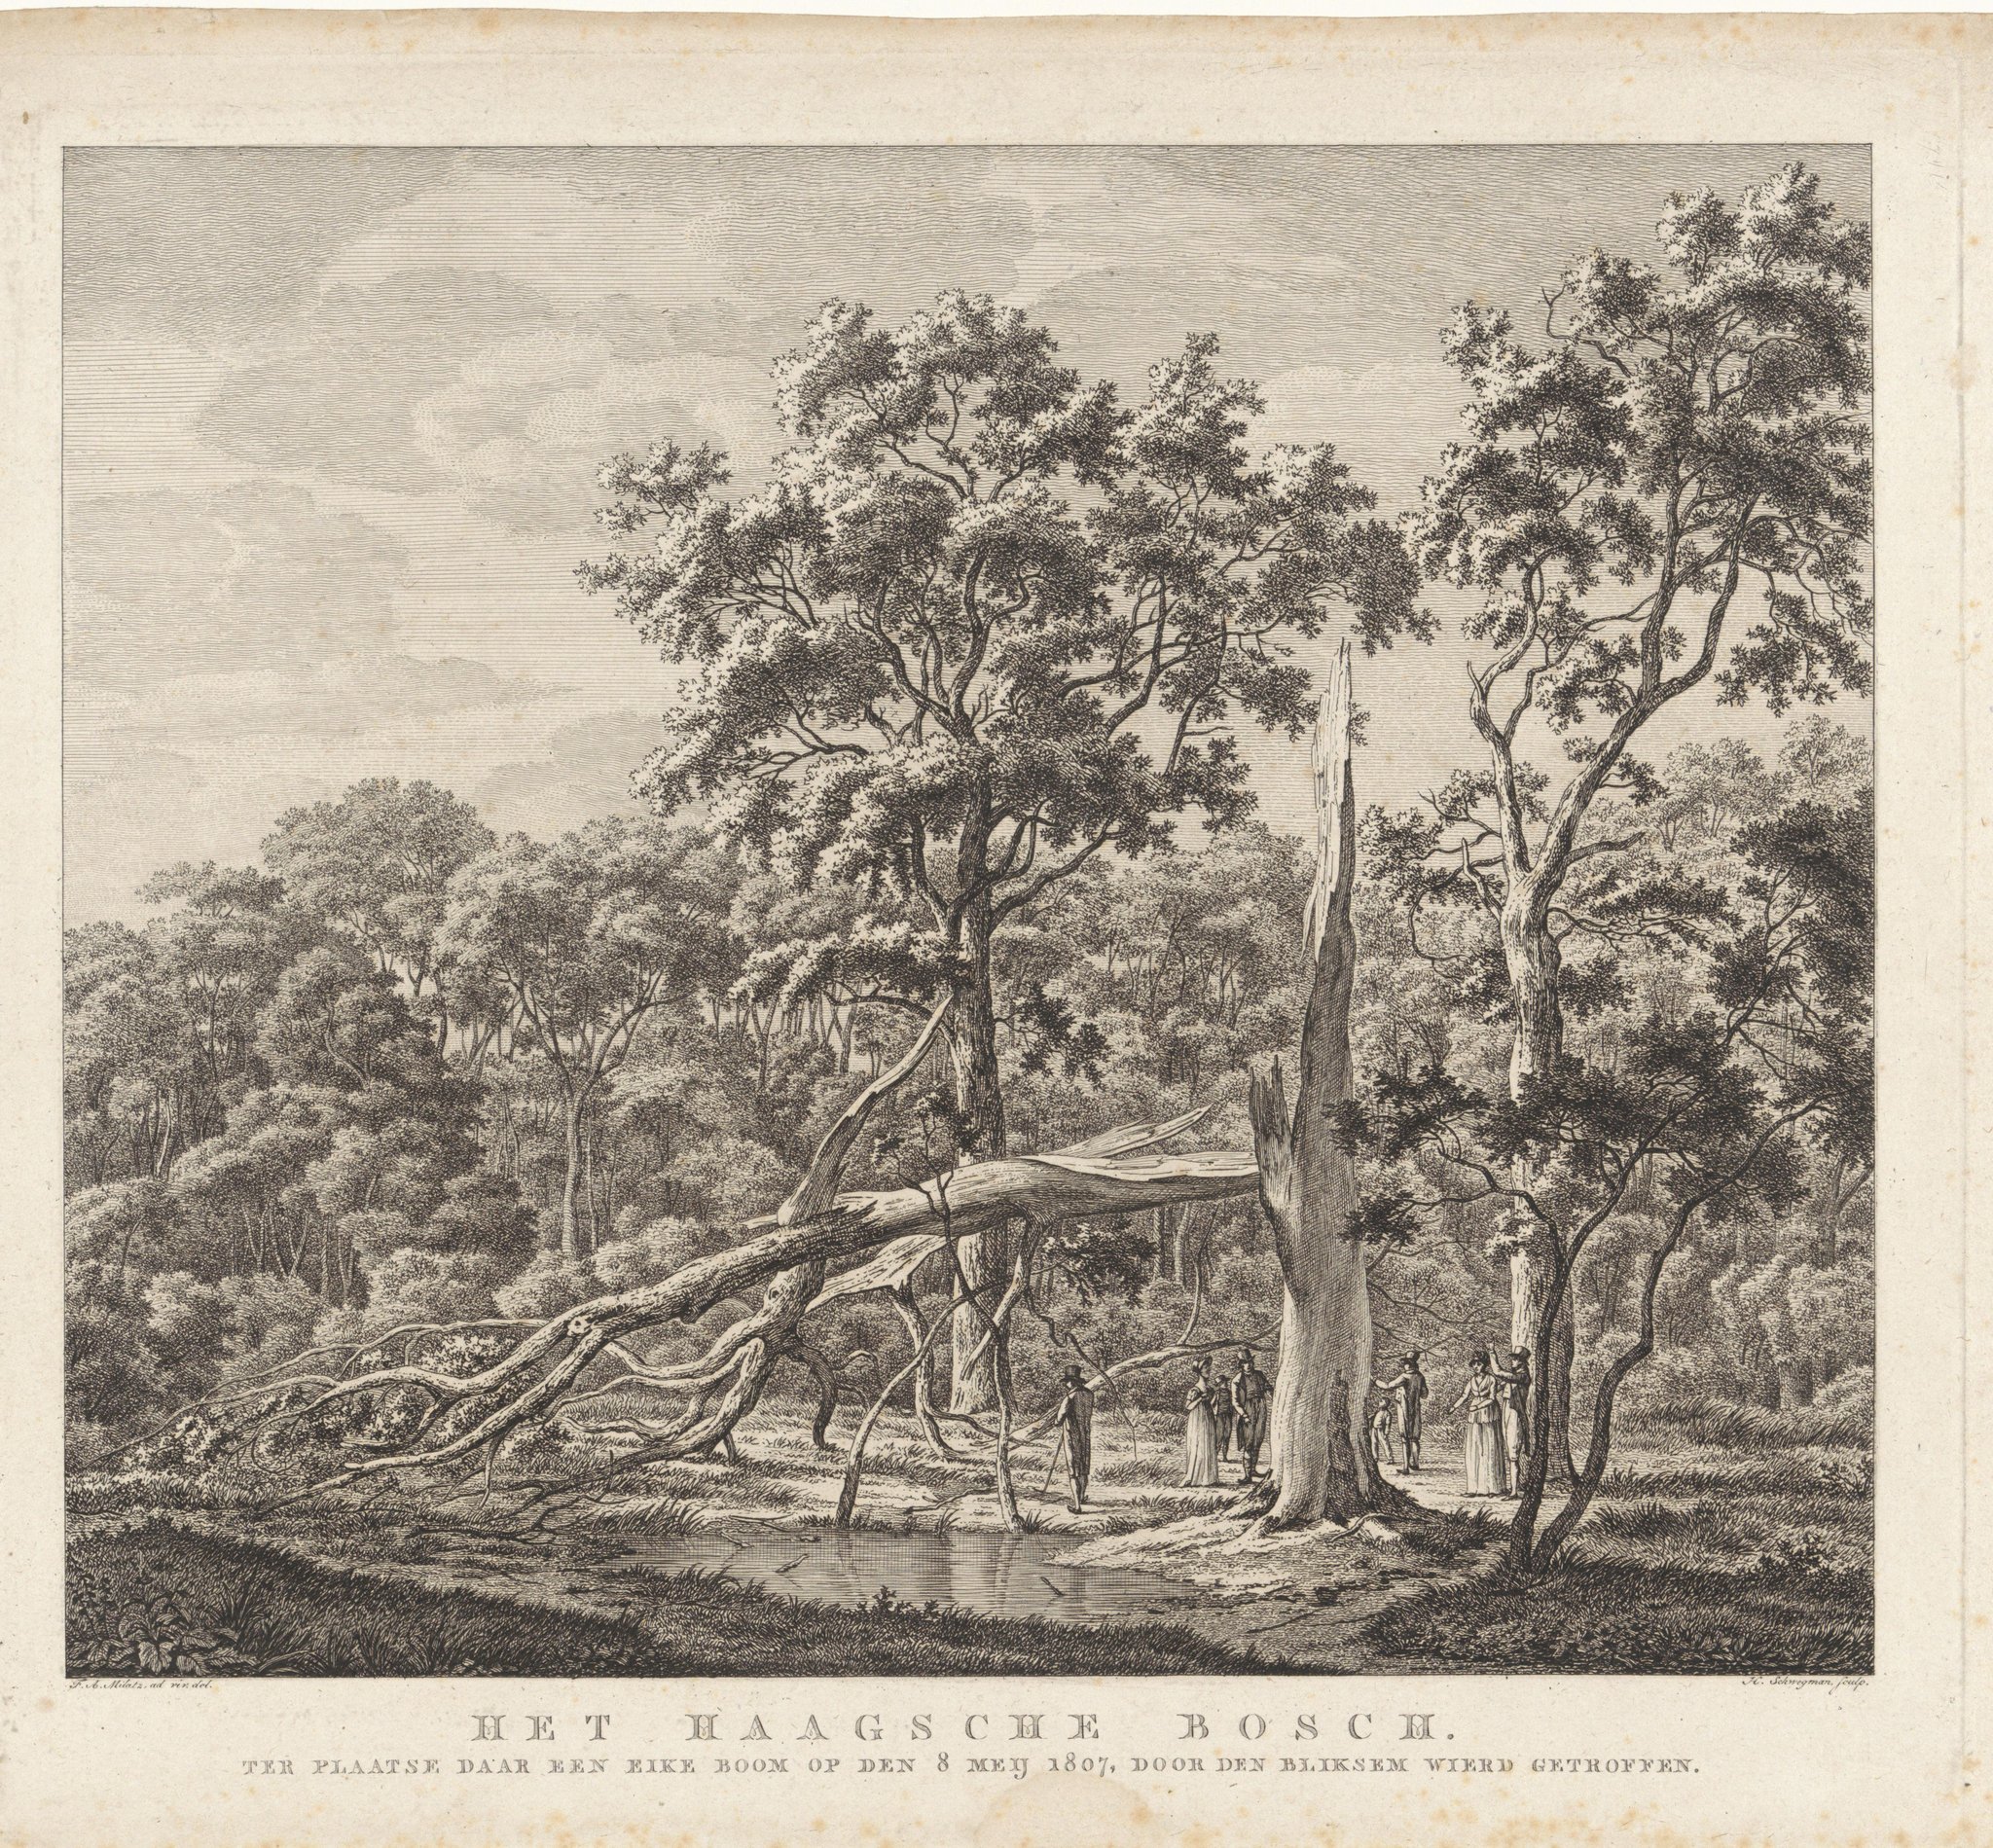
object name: print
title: Het Haagsche Bosch ter plaatse daar een eike boom op den 8 meij 1807, door den bliksem werd getroffen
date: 1807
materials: paper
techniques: engraving, etching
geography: haarlem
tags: forest, wood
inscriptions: collector's mark: Lugt 2228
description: Een door de bliksem getroffen boom in het Haagse Bos wordt bekeken door wandelaars.